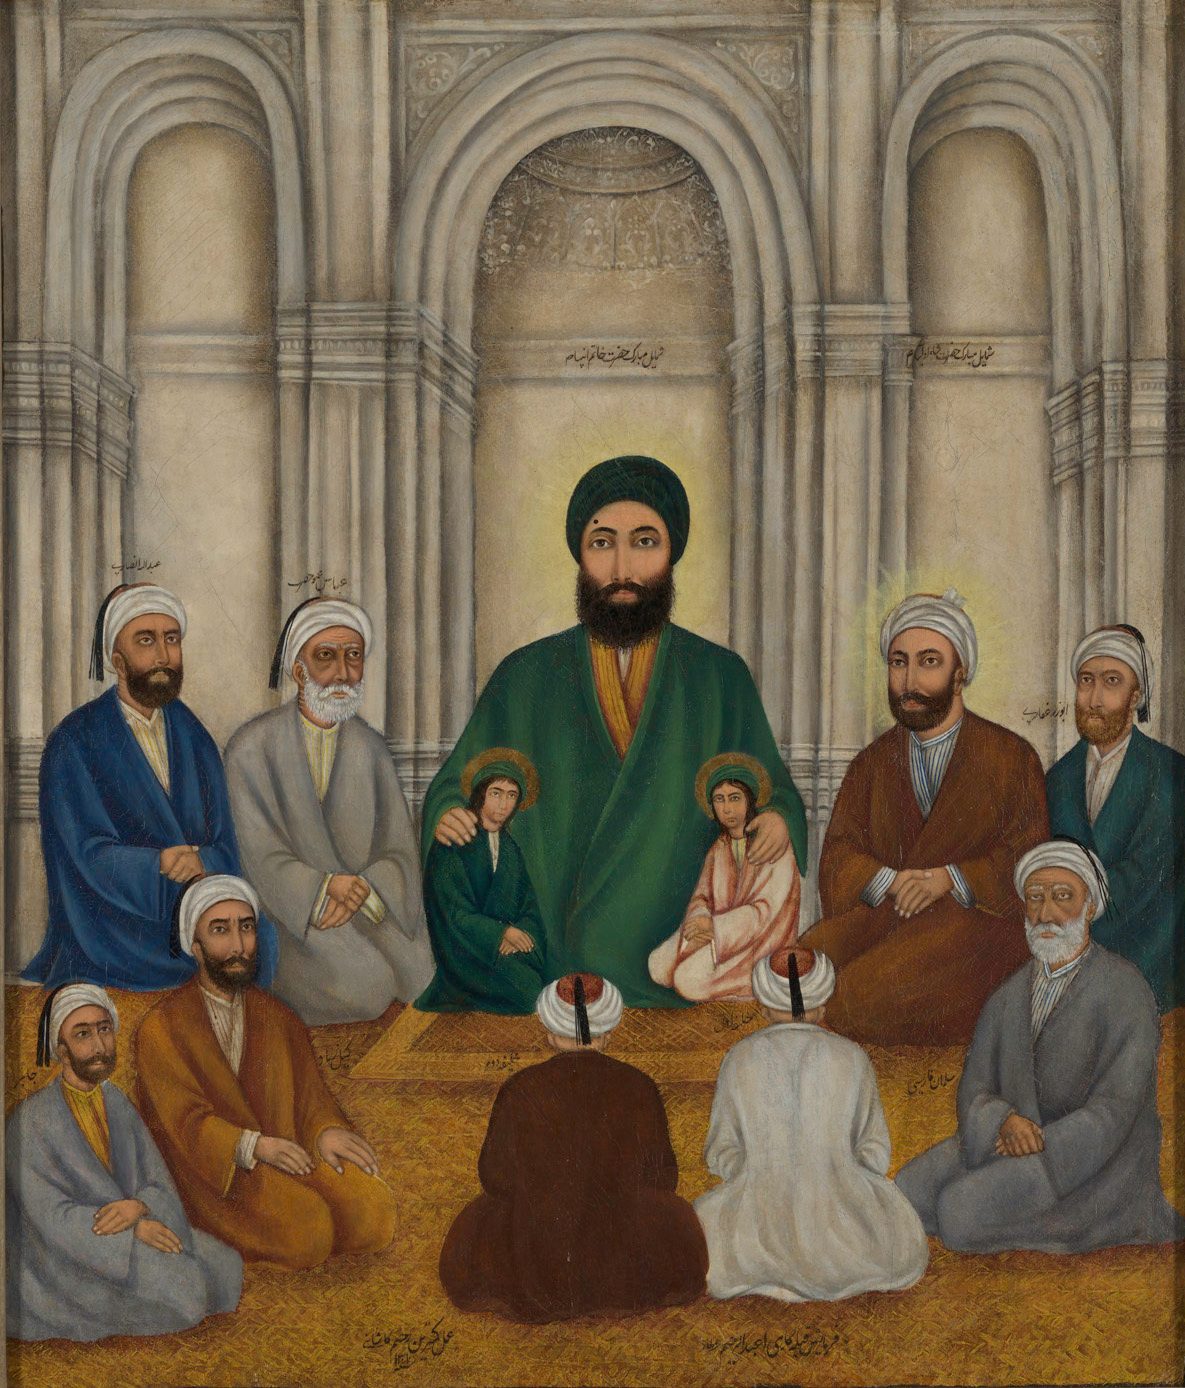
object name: painting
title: People of the Prophet's House with Companions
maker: rahim kashani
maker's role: artist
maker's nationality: iranian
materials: canvas, oil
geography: iran